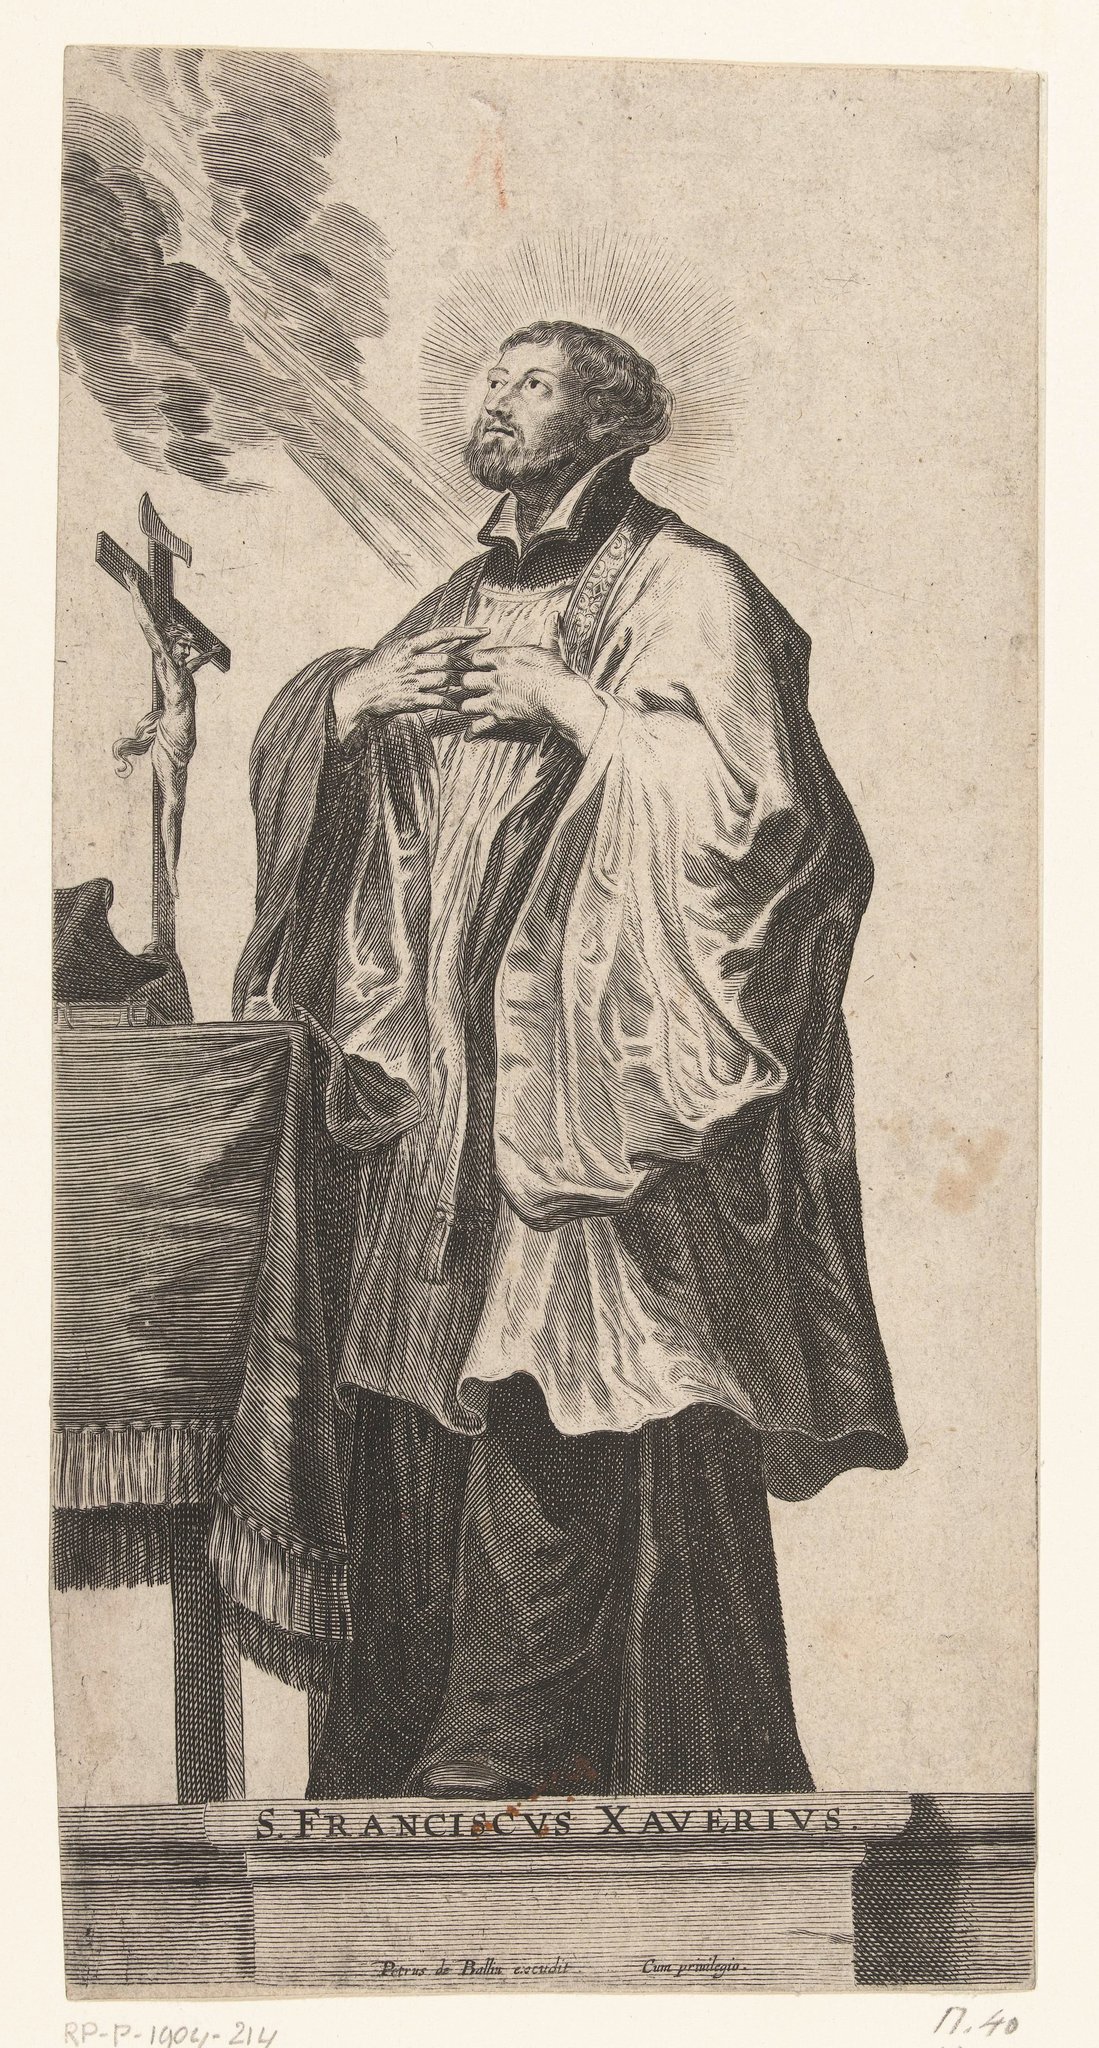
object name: print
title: S. Franciscvs Xaverivs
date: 1623-1660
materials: paper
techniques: engraving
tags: the jesuit missionary francis xavier; possible attributes: cross, crucifix, flaming heart, indian, lily, torch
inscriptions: collector's mark: Lugt 2228